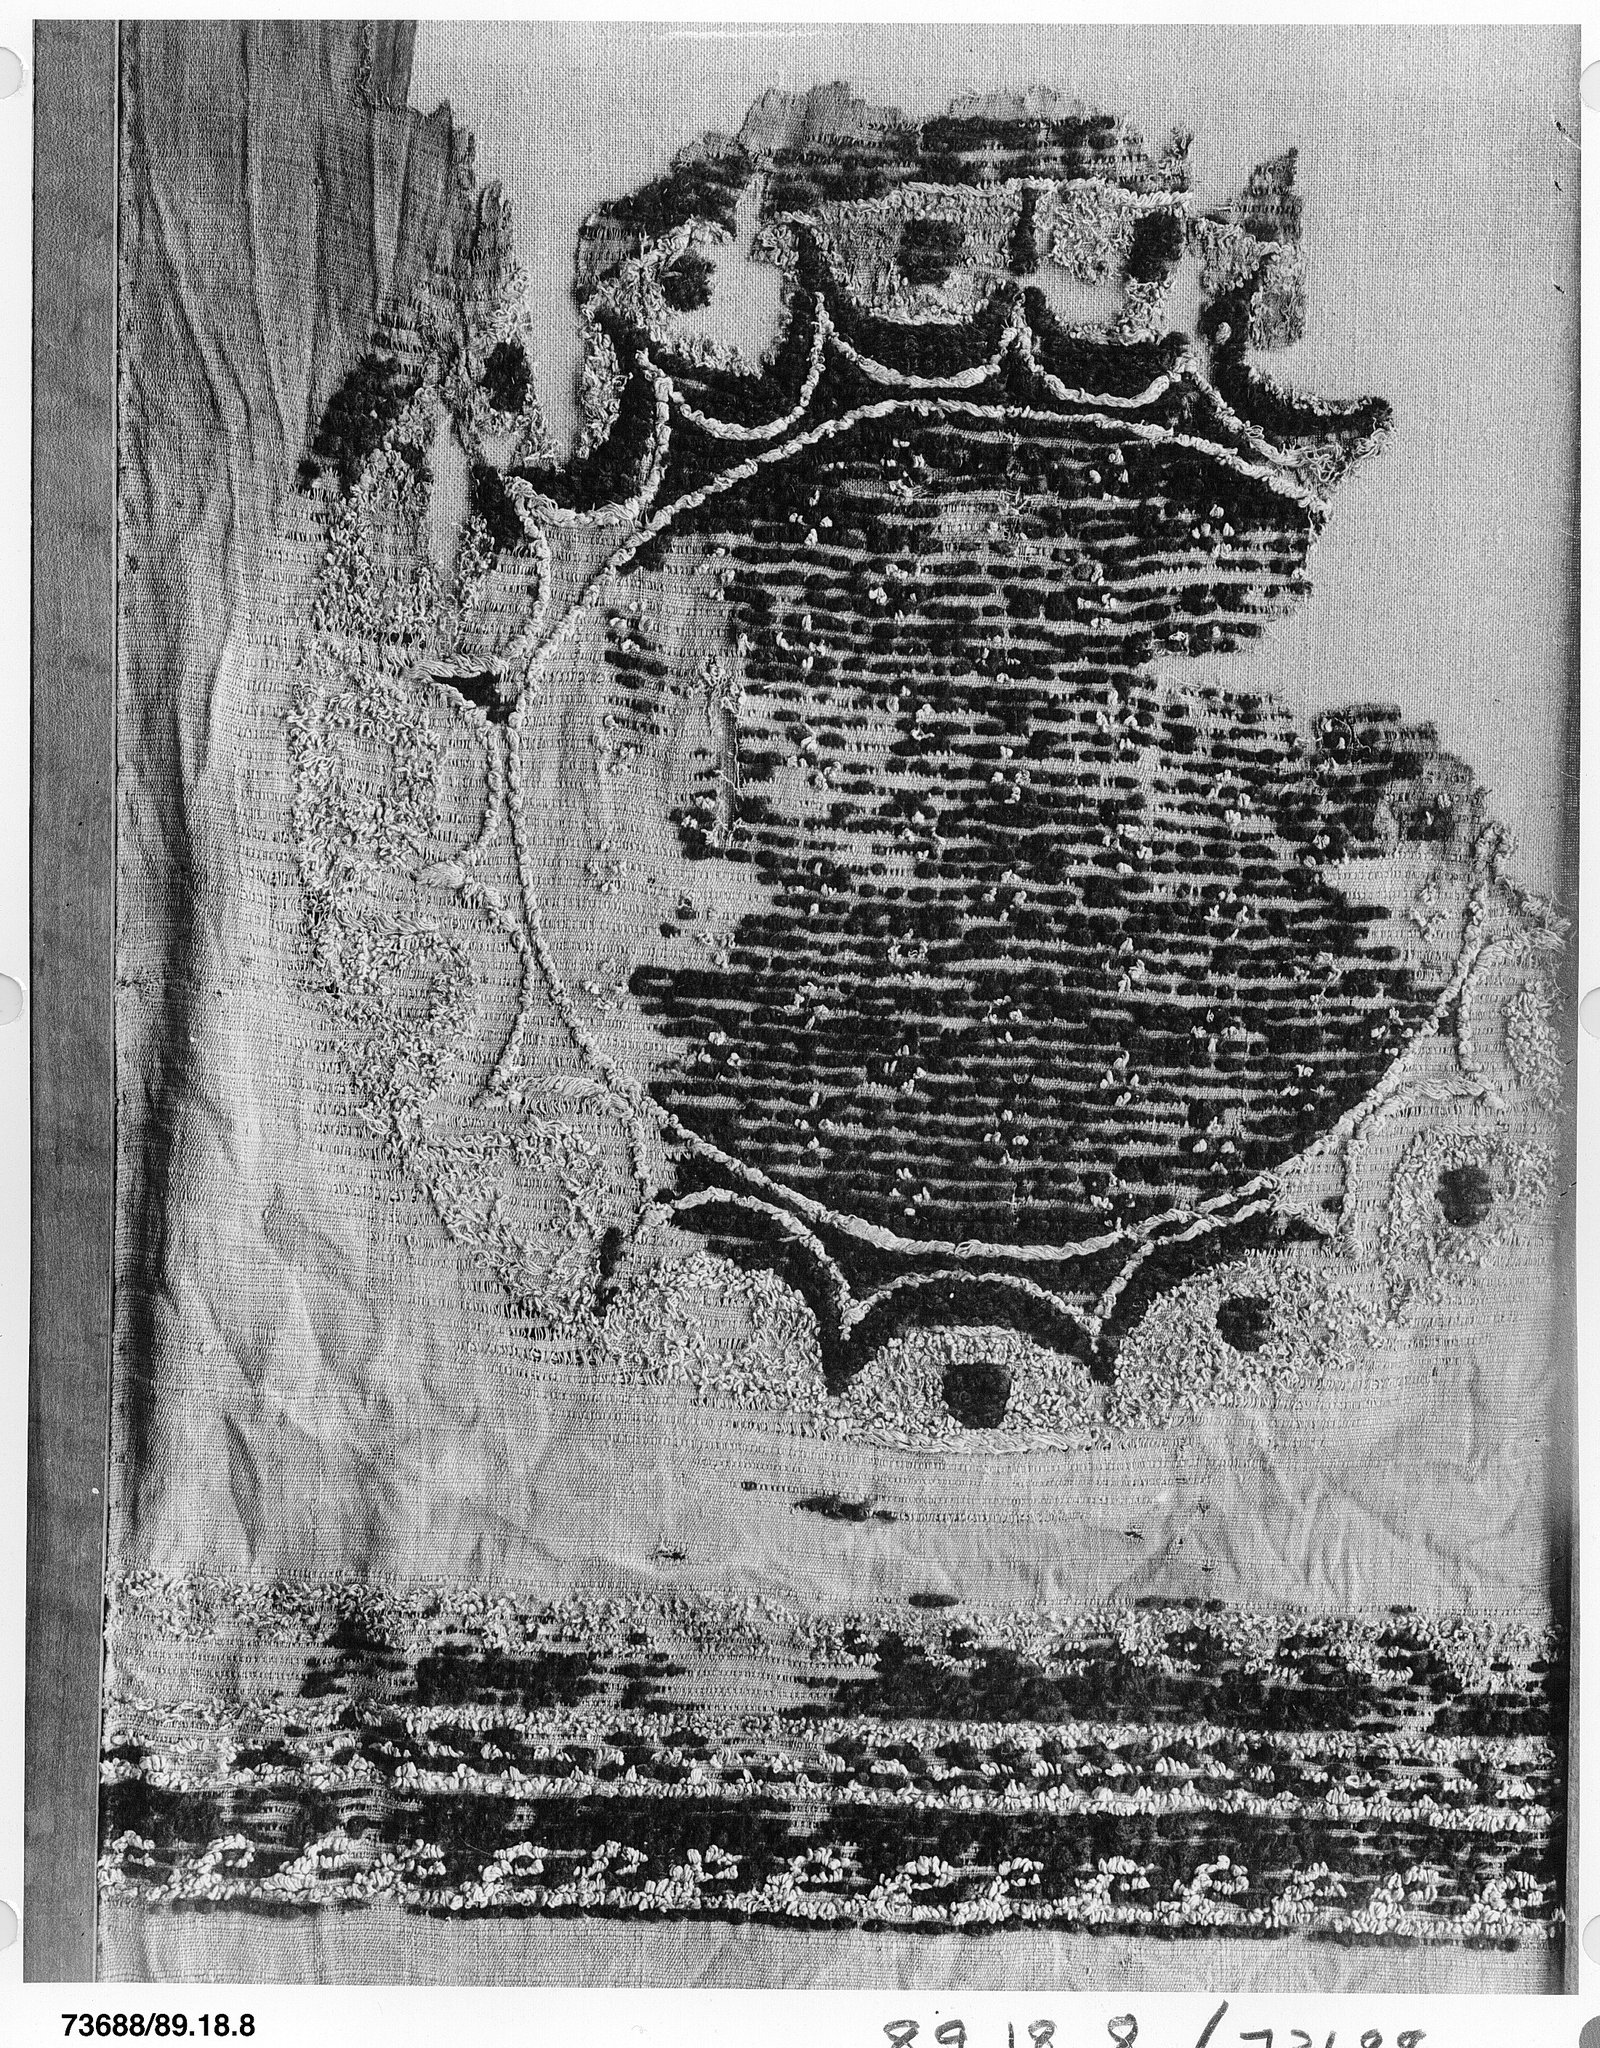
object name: textile fragment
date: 201-400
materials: linen, wool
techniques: weave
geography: egypt